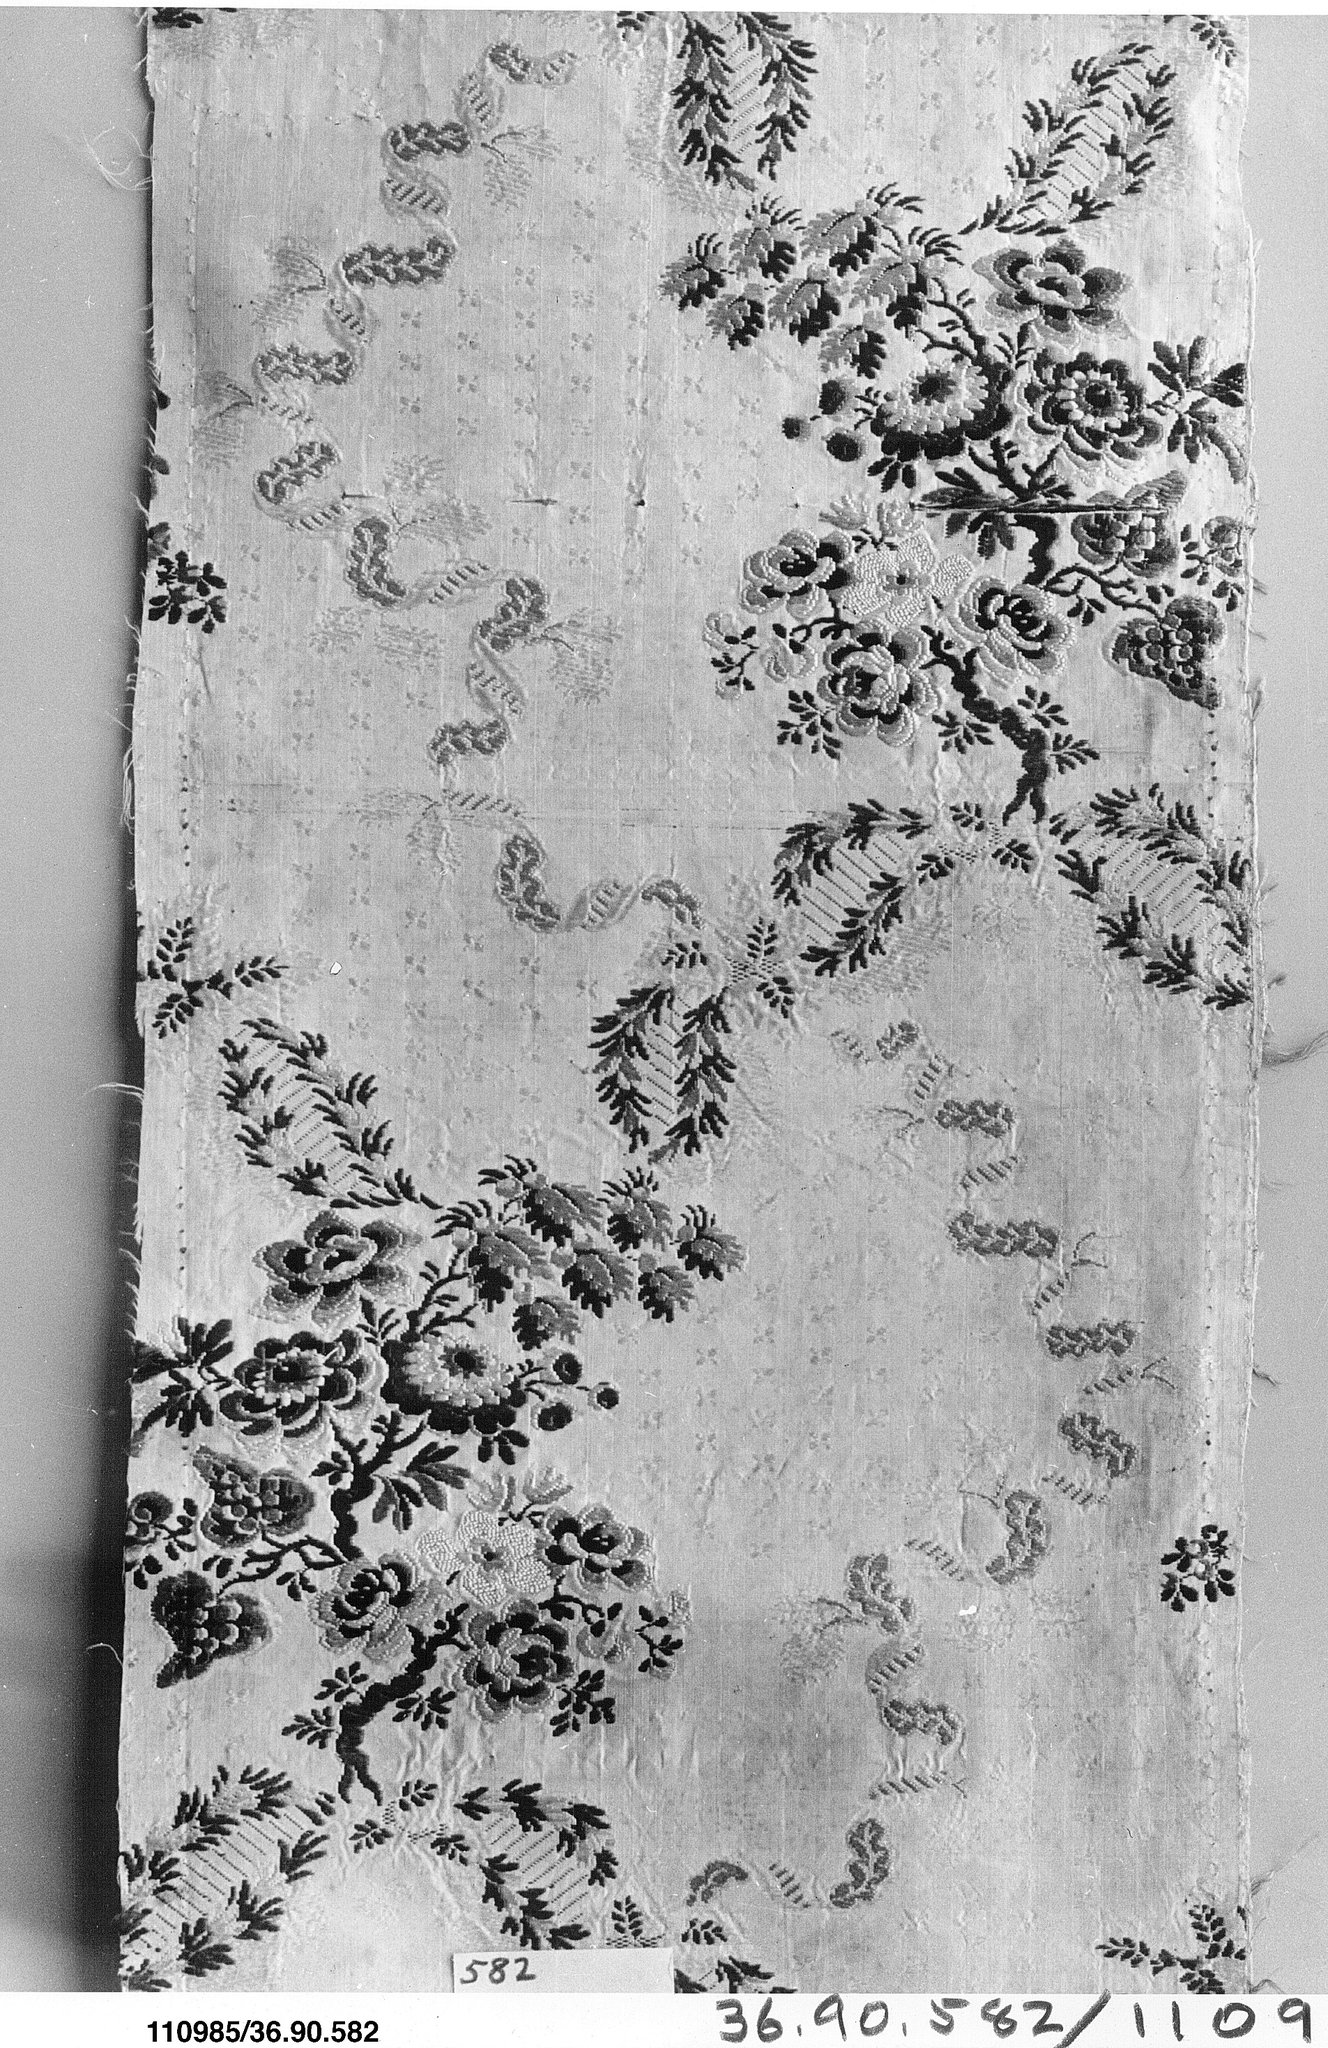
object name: piece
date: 1734-1766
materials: silk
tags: flowers